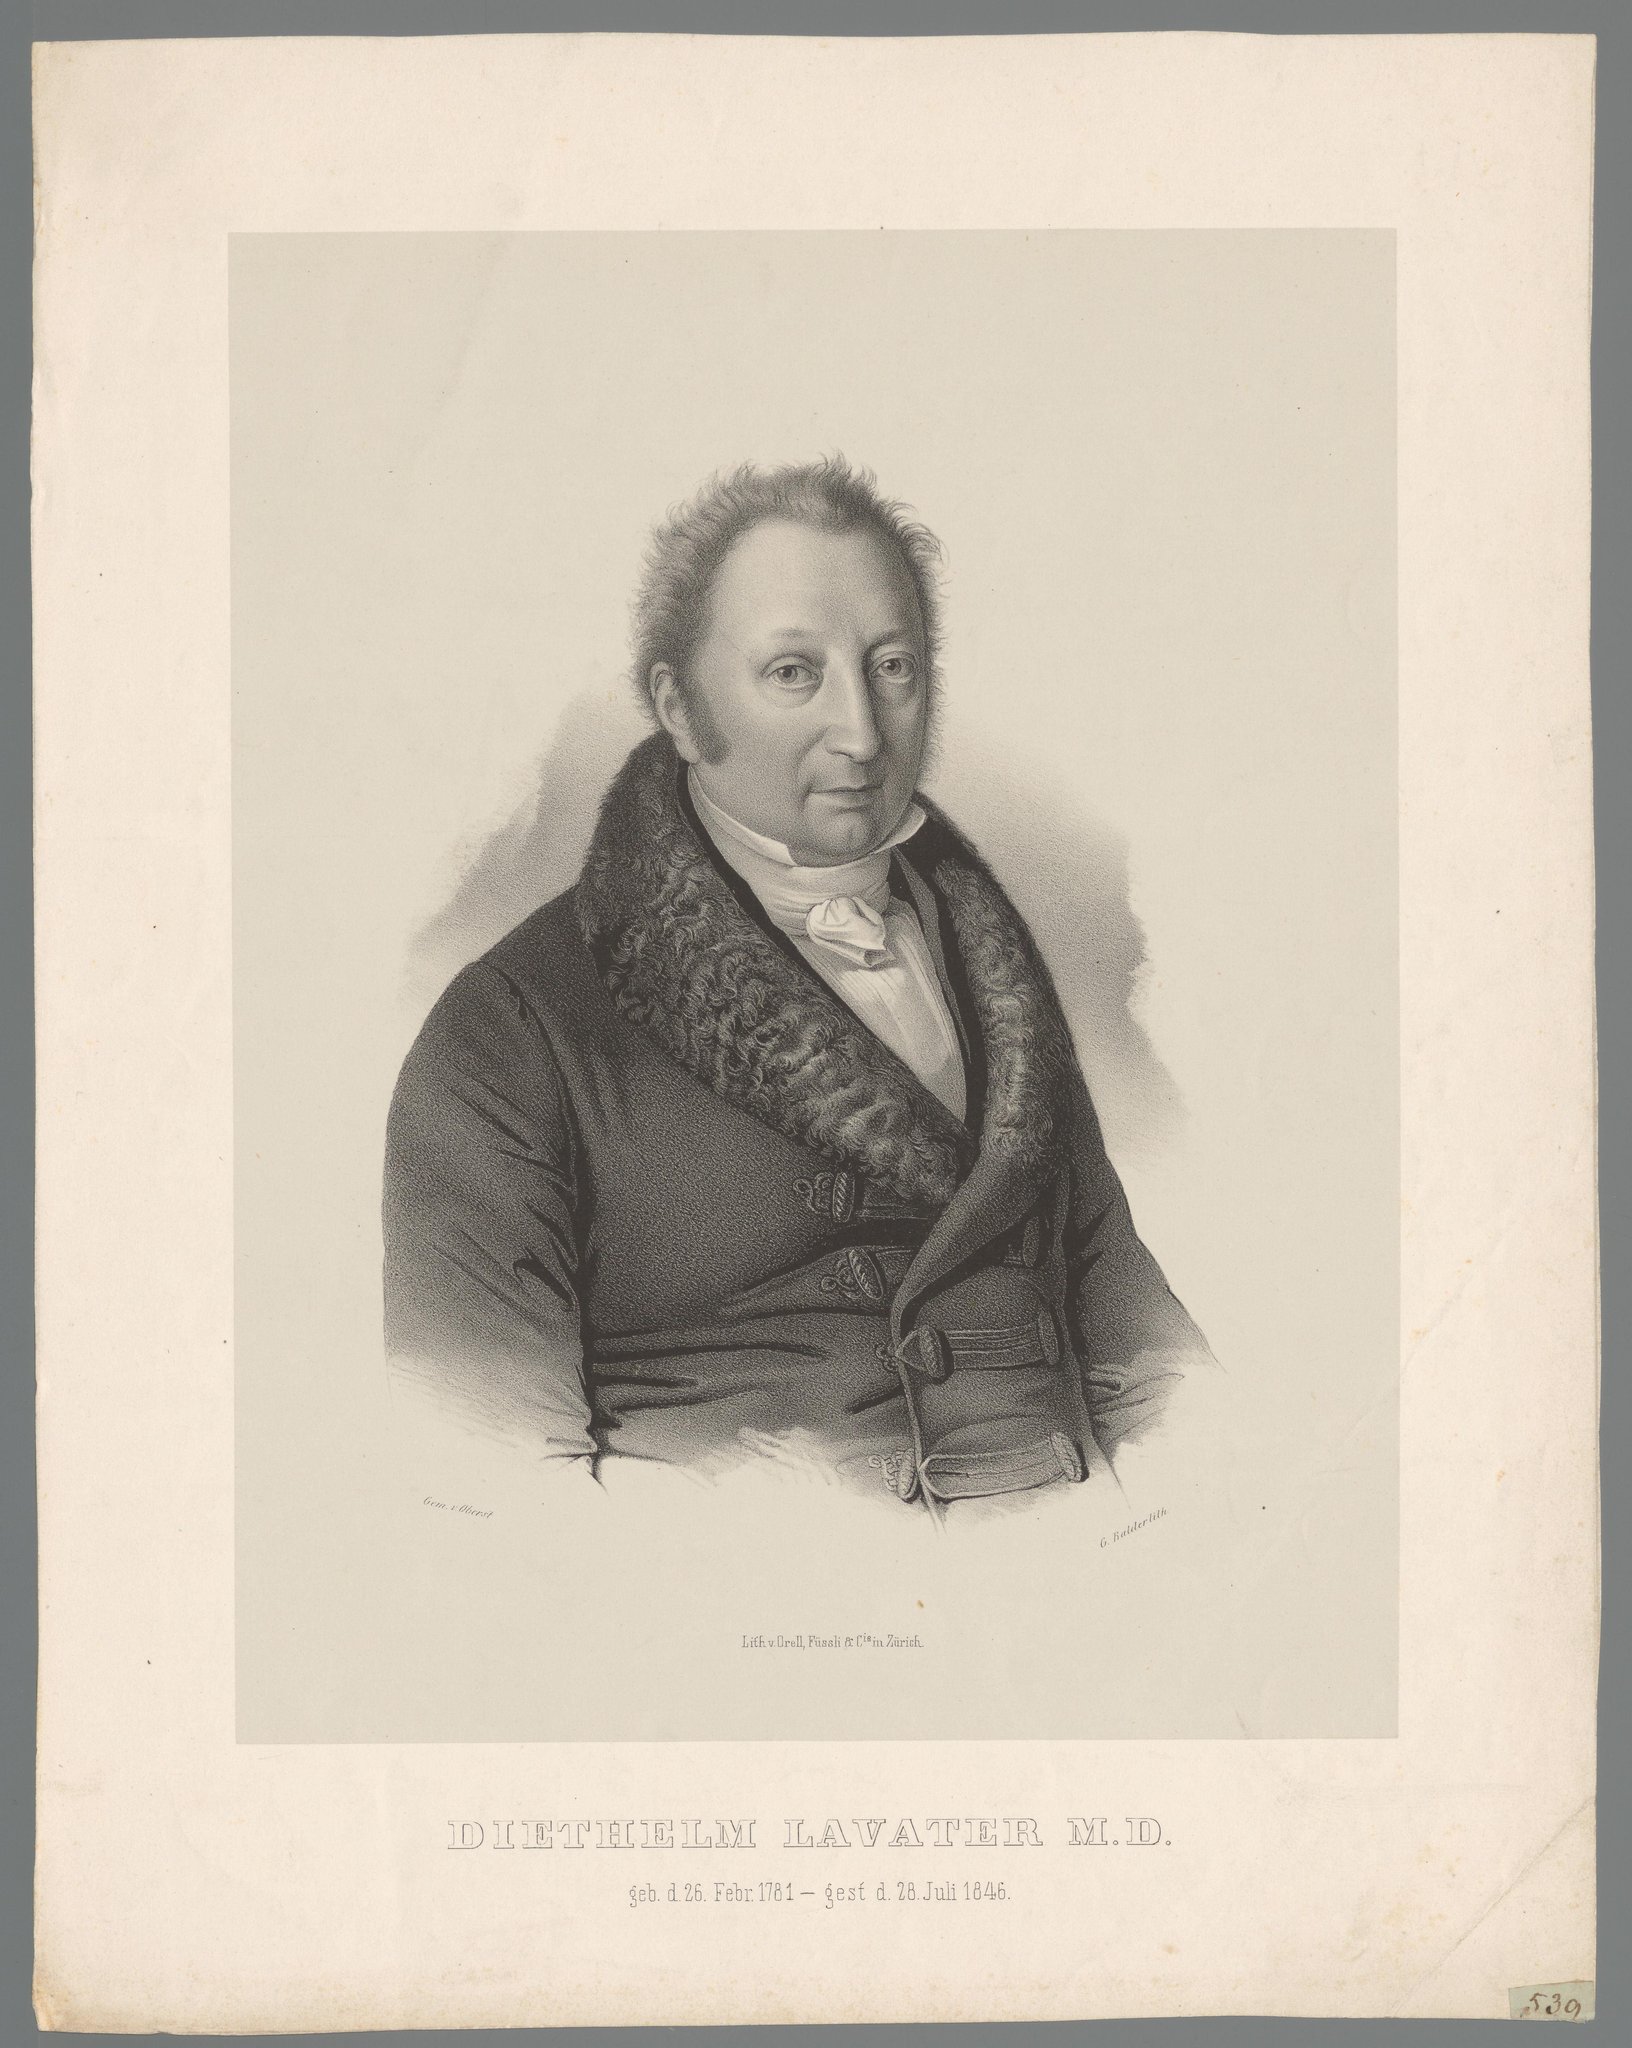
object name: print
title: Portret van Diethelm Lavater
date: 1820-1882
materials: paper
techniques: lithograph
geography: zurich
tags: historical persons, physician, doctor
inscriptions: collector's mark: Lugt 2228